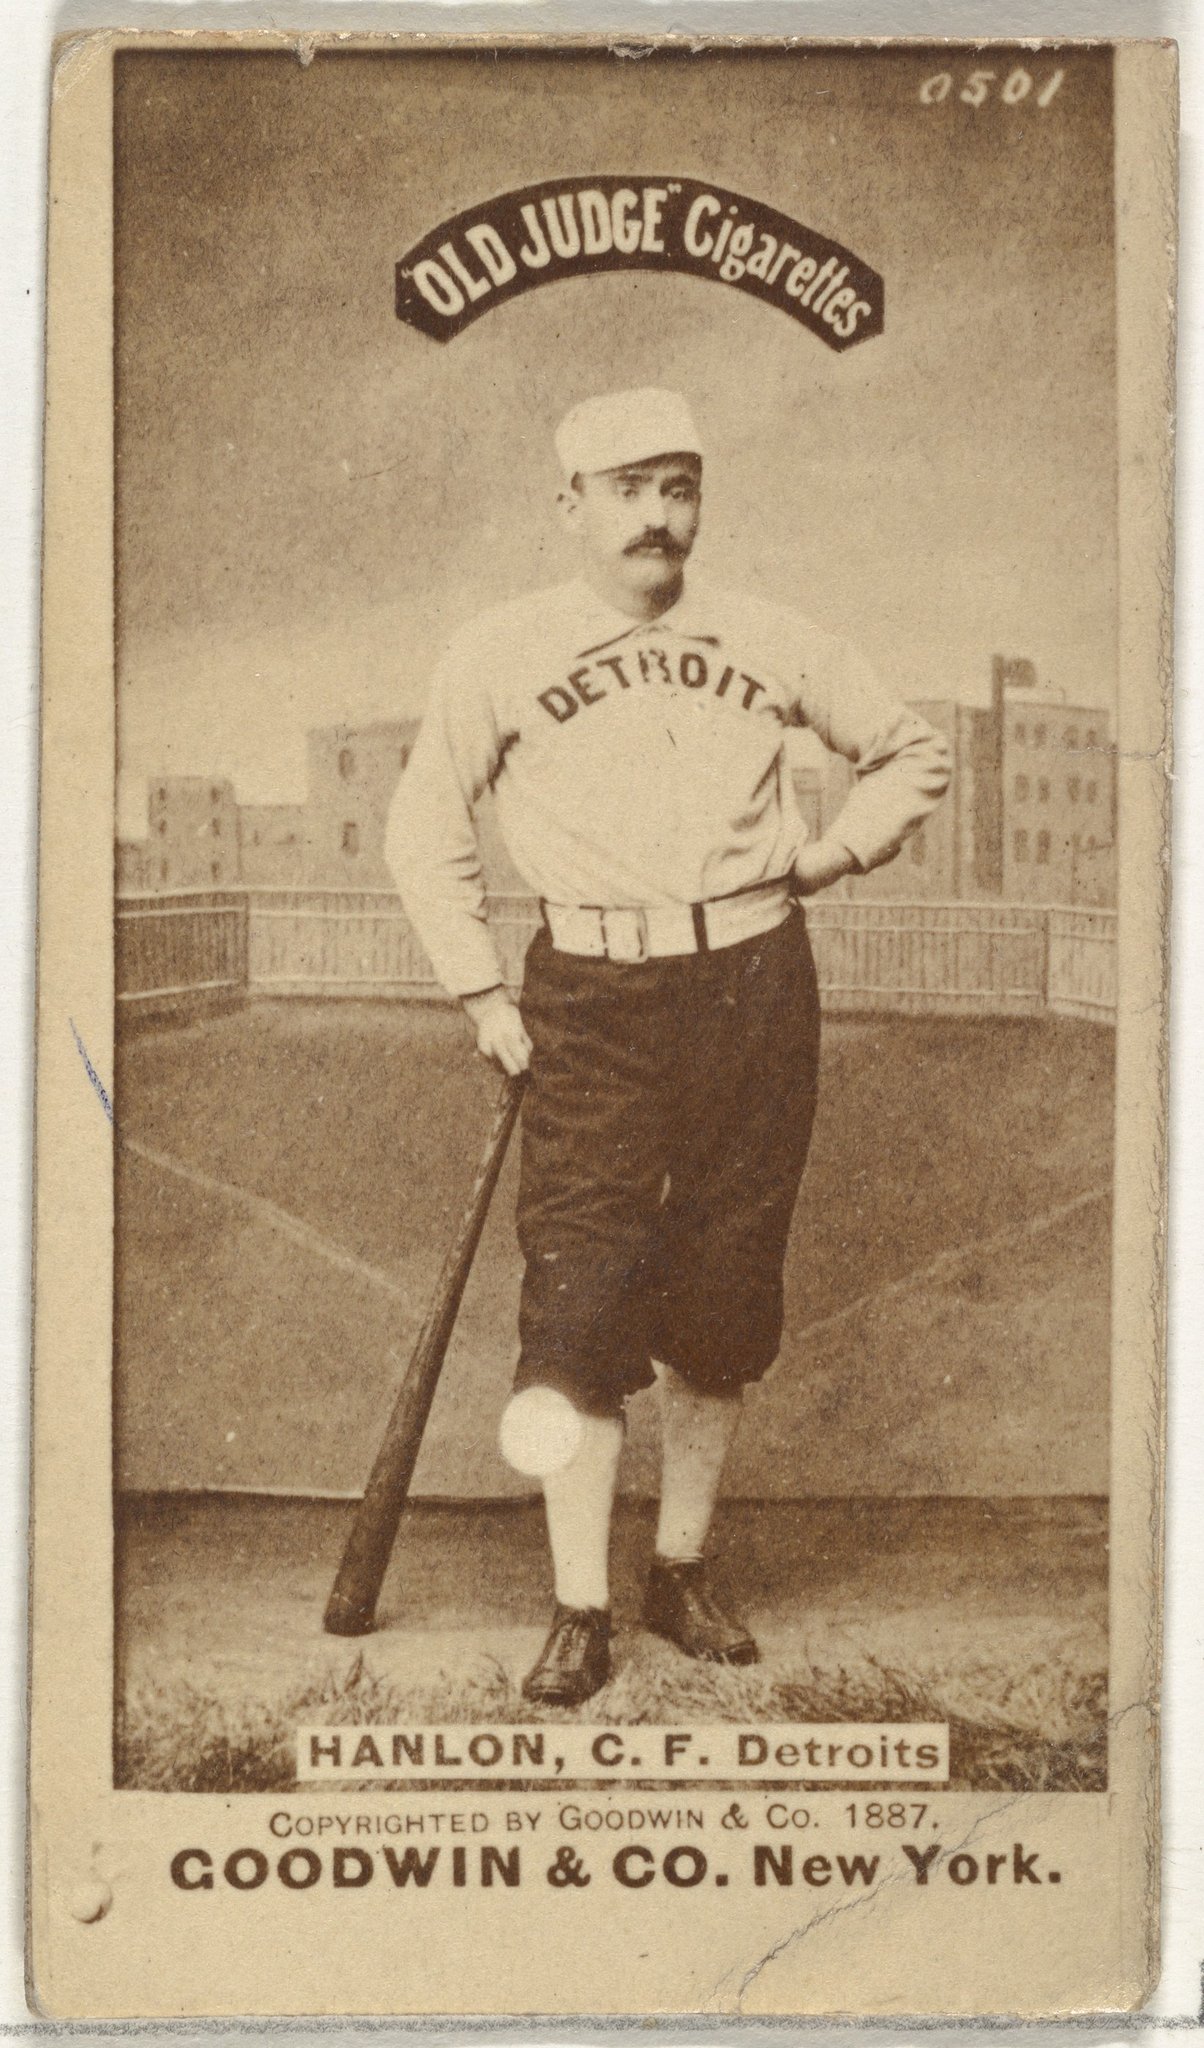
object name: baseball card, photograph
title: Edward Hugh "Ned" Hanlon, Center Field, Detroit Wolverines, from the Old Judge series (N172) for Old Judge Cigarettes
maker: goodwin & company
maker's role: publisher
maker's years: 1850-1950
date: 1887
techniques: albumen silver print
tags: men,portraits,baseball,athletes